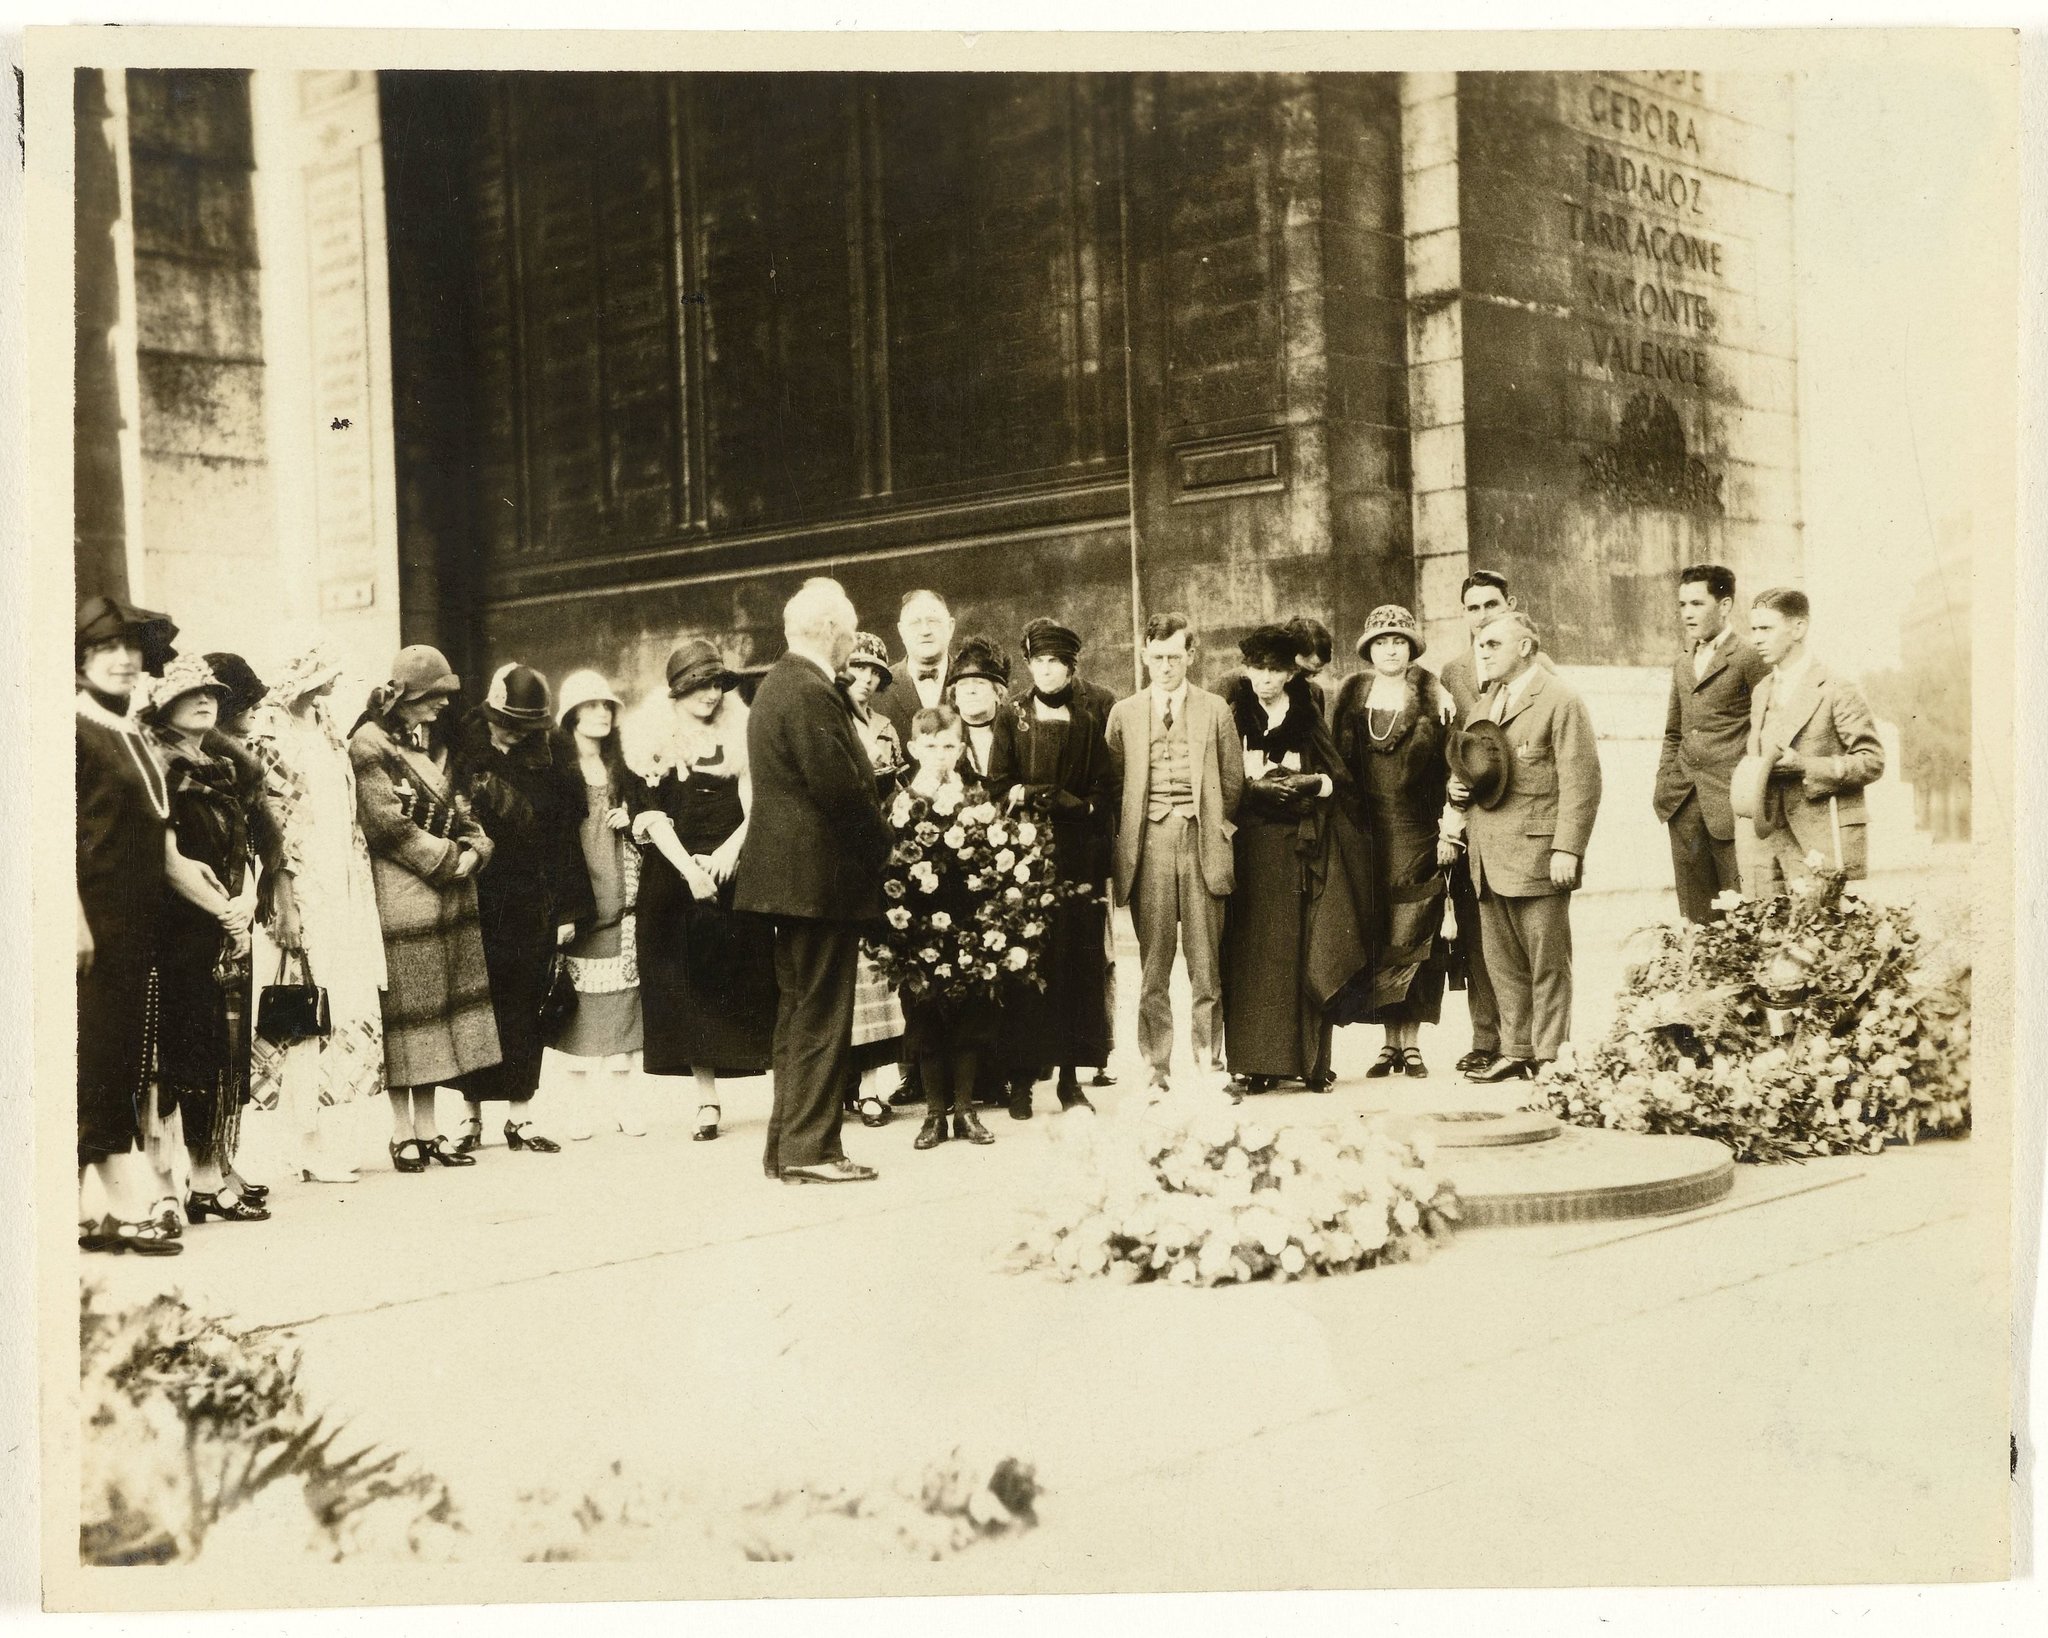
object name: photograph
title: Groep Amerikaanse toeristen bij een herdenking bij de Arc de Triomphe in Parijs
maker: Anonymous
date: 1921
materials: paper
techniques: gelatin silver print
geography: paris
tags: tourism, paris